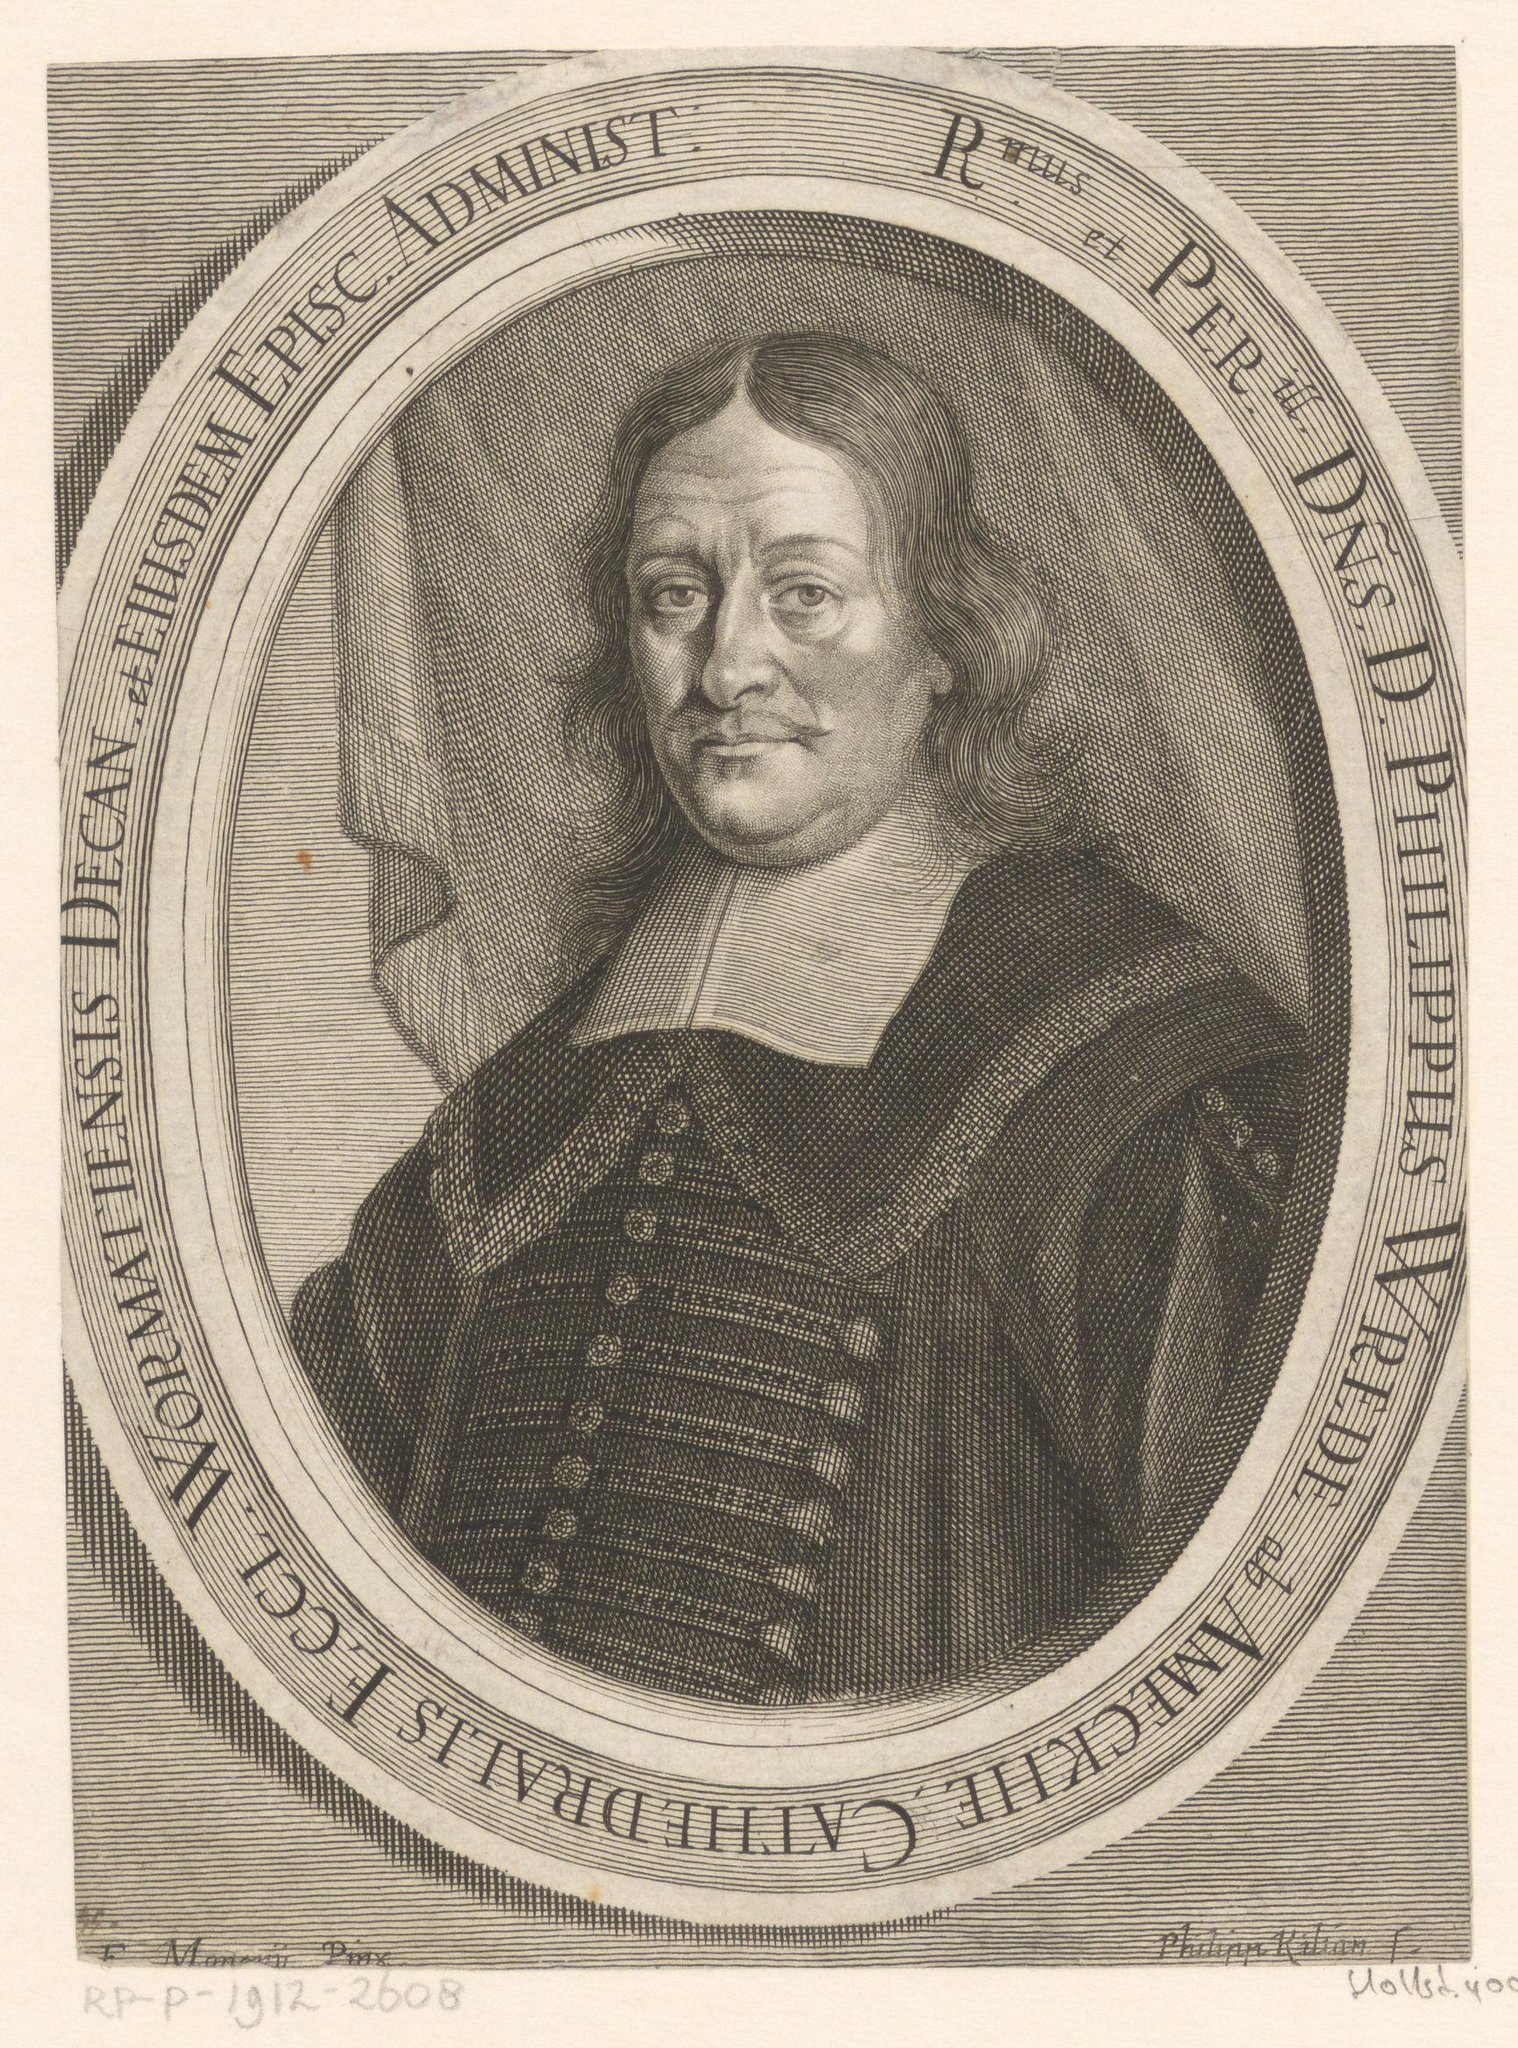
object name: print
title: Portret van Philipp von Wrede zu Amecke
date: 1638-1693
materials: paper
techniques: engraving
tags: theologian, historical persons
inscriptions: collector's mark: Lugt 2228